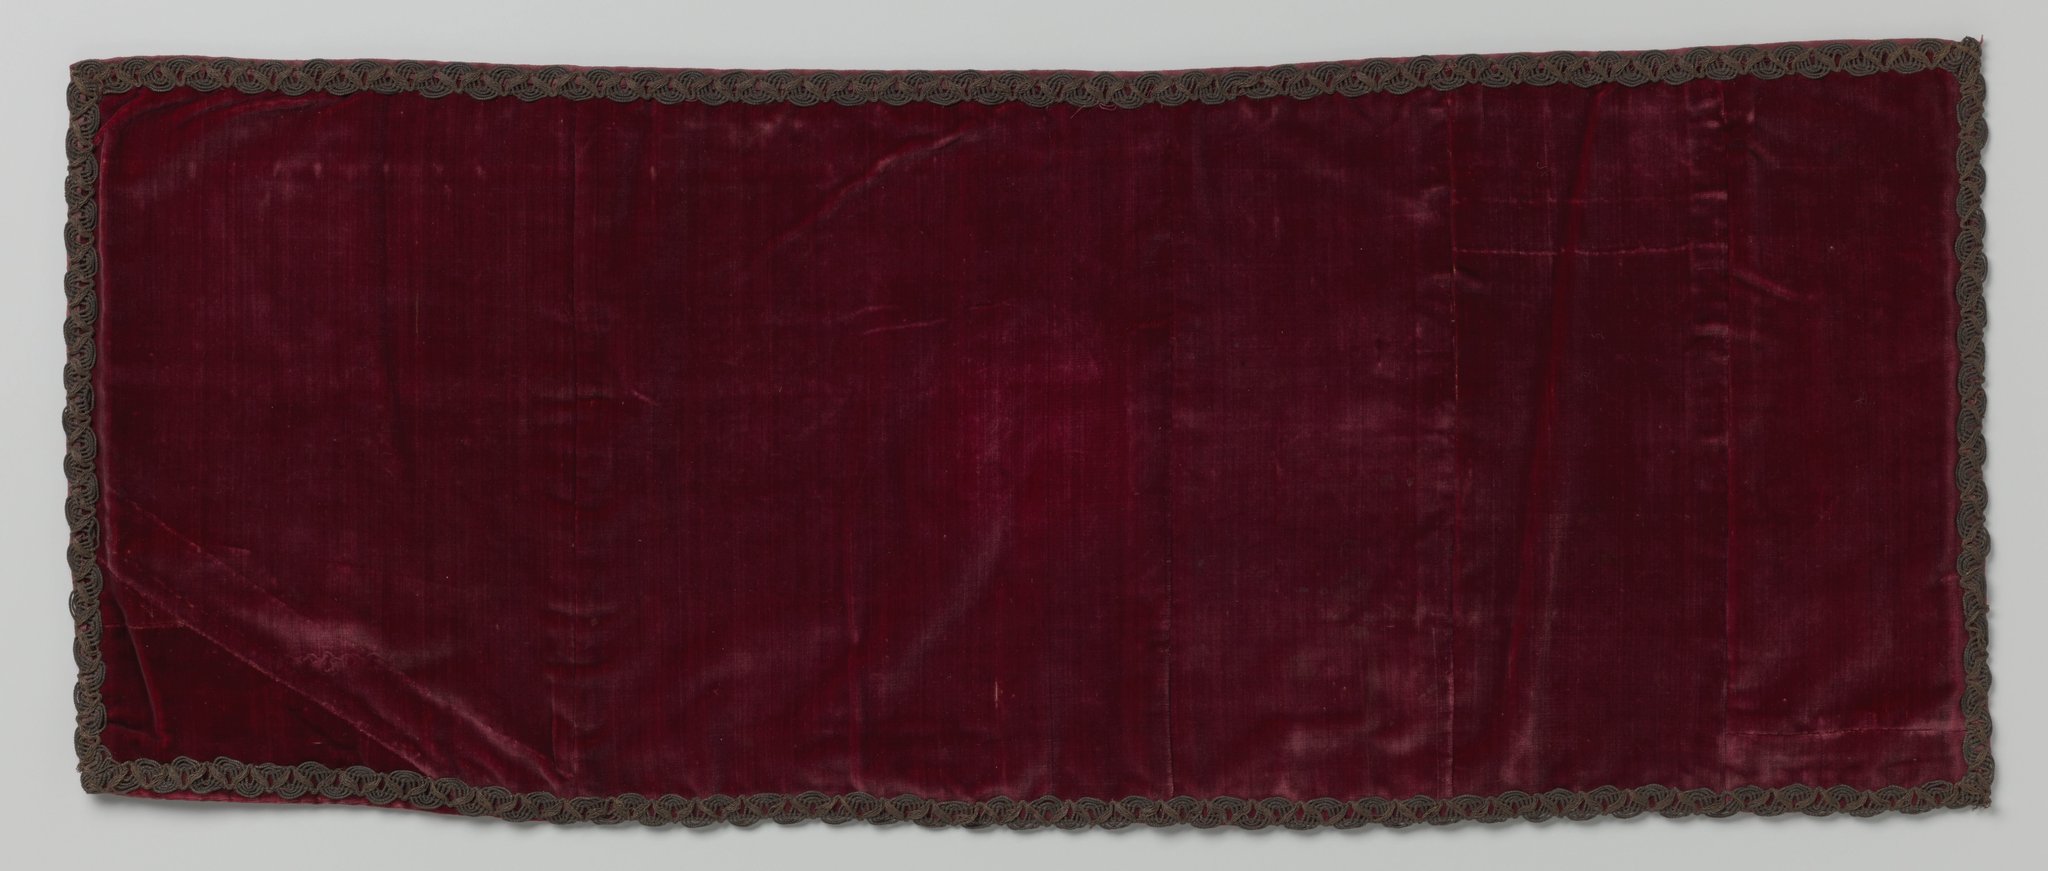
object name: kleed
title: Kleed van rode zijden fluweel met een satijnen voering.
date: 1600-1699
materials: cotton, textile, silk, velvet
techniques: weave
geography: italy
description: Een kleedje van rood zijden fluweel, samengesteld uit negen stukken. Omrand door een zwart getint gouden galon. Voering van rode satin.